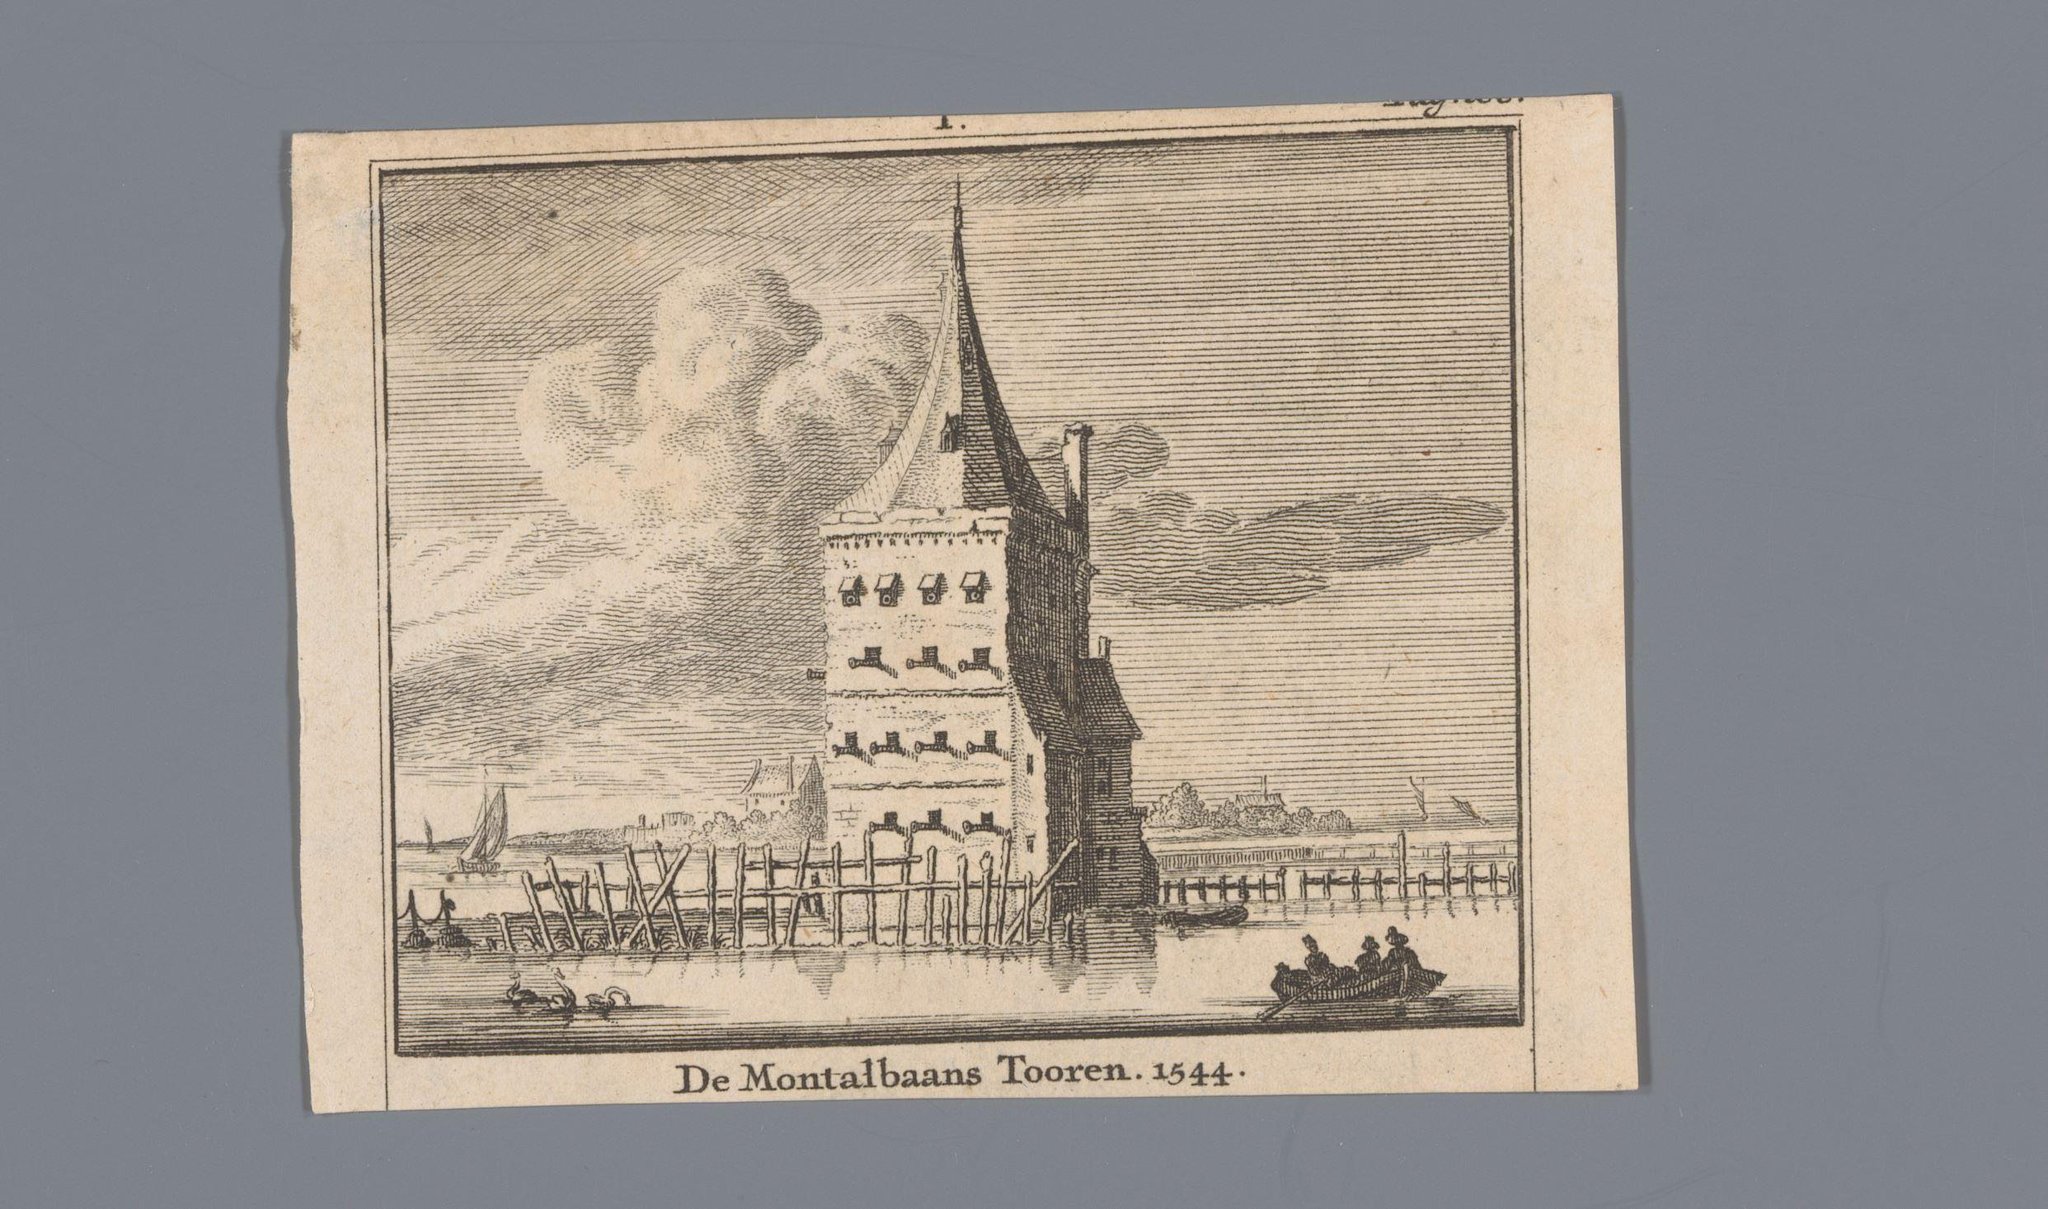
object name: print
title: De Montalbaans tooren 1544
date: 1723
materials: paper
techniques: etching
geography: amsterdam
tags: towers ~ fortified city, rowing-boat, canoe, etc.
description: Prent uit: Willink, Daniël. Daniël Willinks Amsterdamsche Buitensingel nevens de omleggende dorpen (...). Amsterdam: Andries van Damme, 1723, p. 188-189. En in: Willink, Daniël. Daniël Willinks Amsterdamsche Buitensingel, nevens de omleggende dorpen (...). Tweede druk. Amsterdam: Arendt van Huyssteen, 1738, p. 188-189.